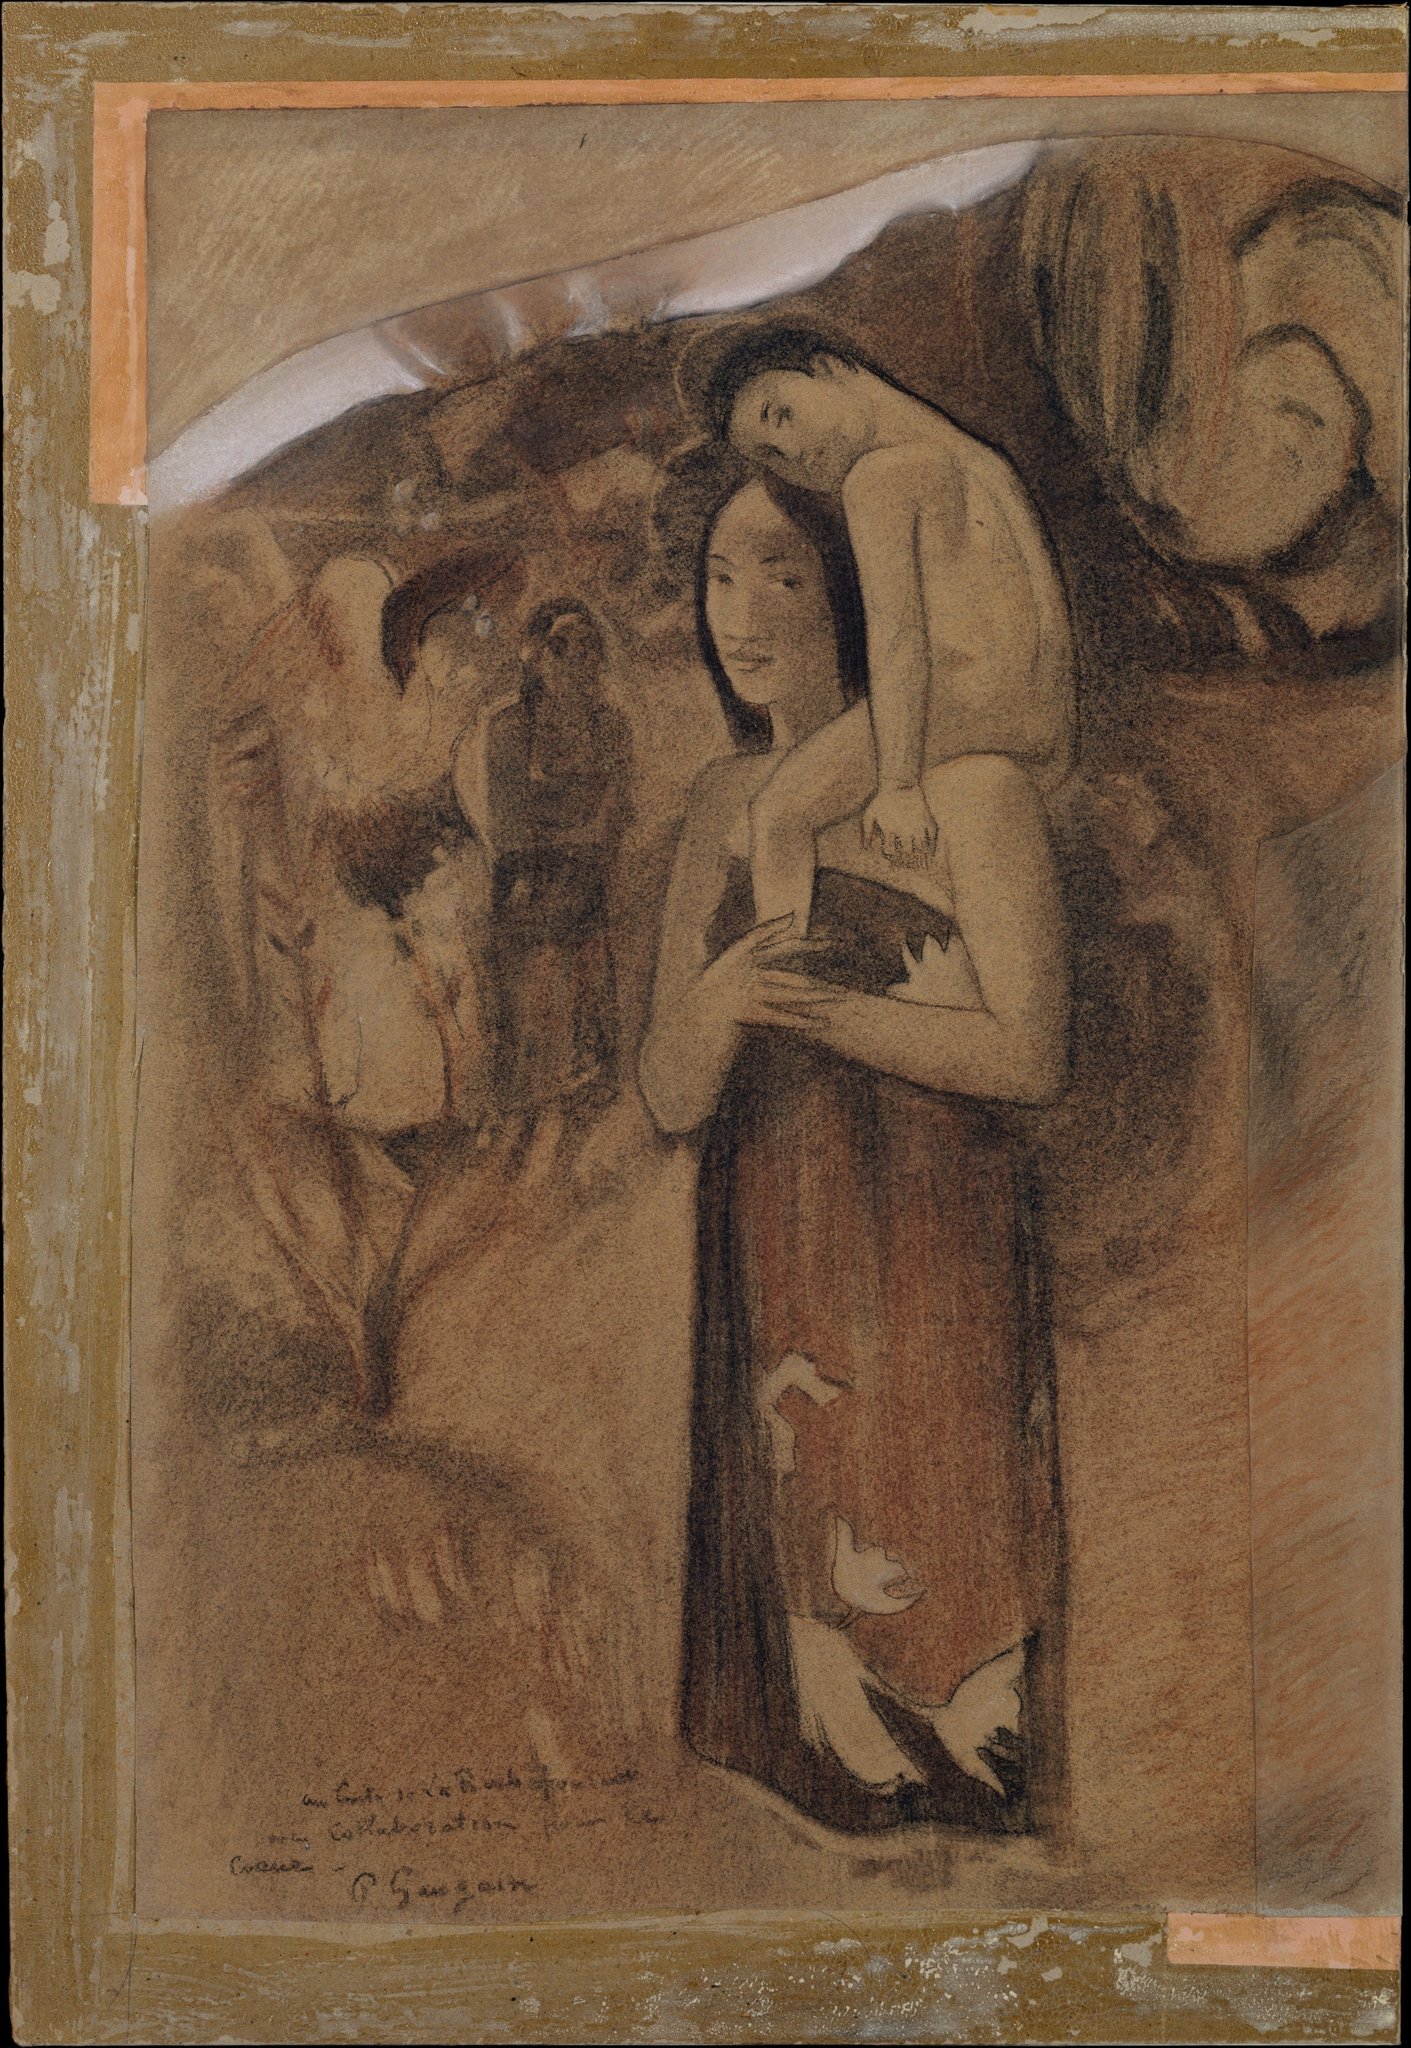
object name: drawing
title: Hail Mary (Ia Orana Maria)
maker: paul gauguin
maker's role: artist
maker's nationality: french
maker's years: 1848-1903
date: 1893-1895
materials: chalk, charcoal, pastel, paper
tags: infants,women